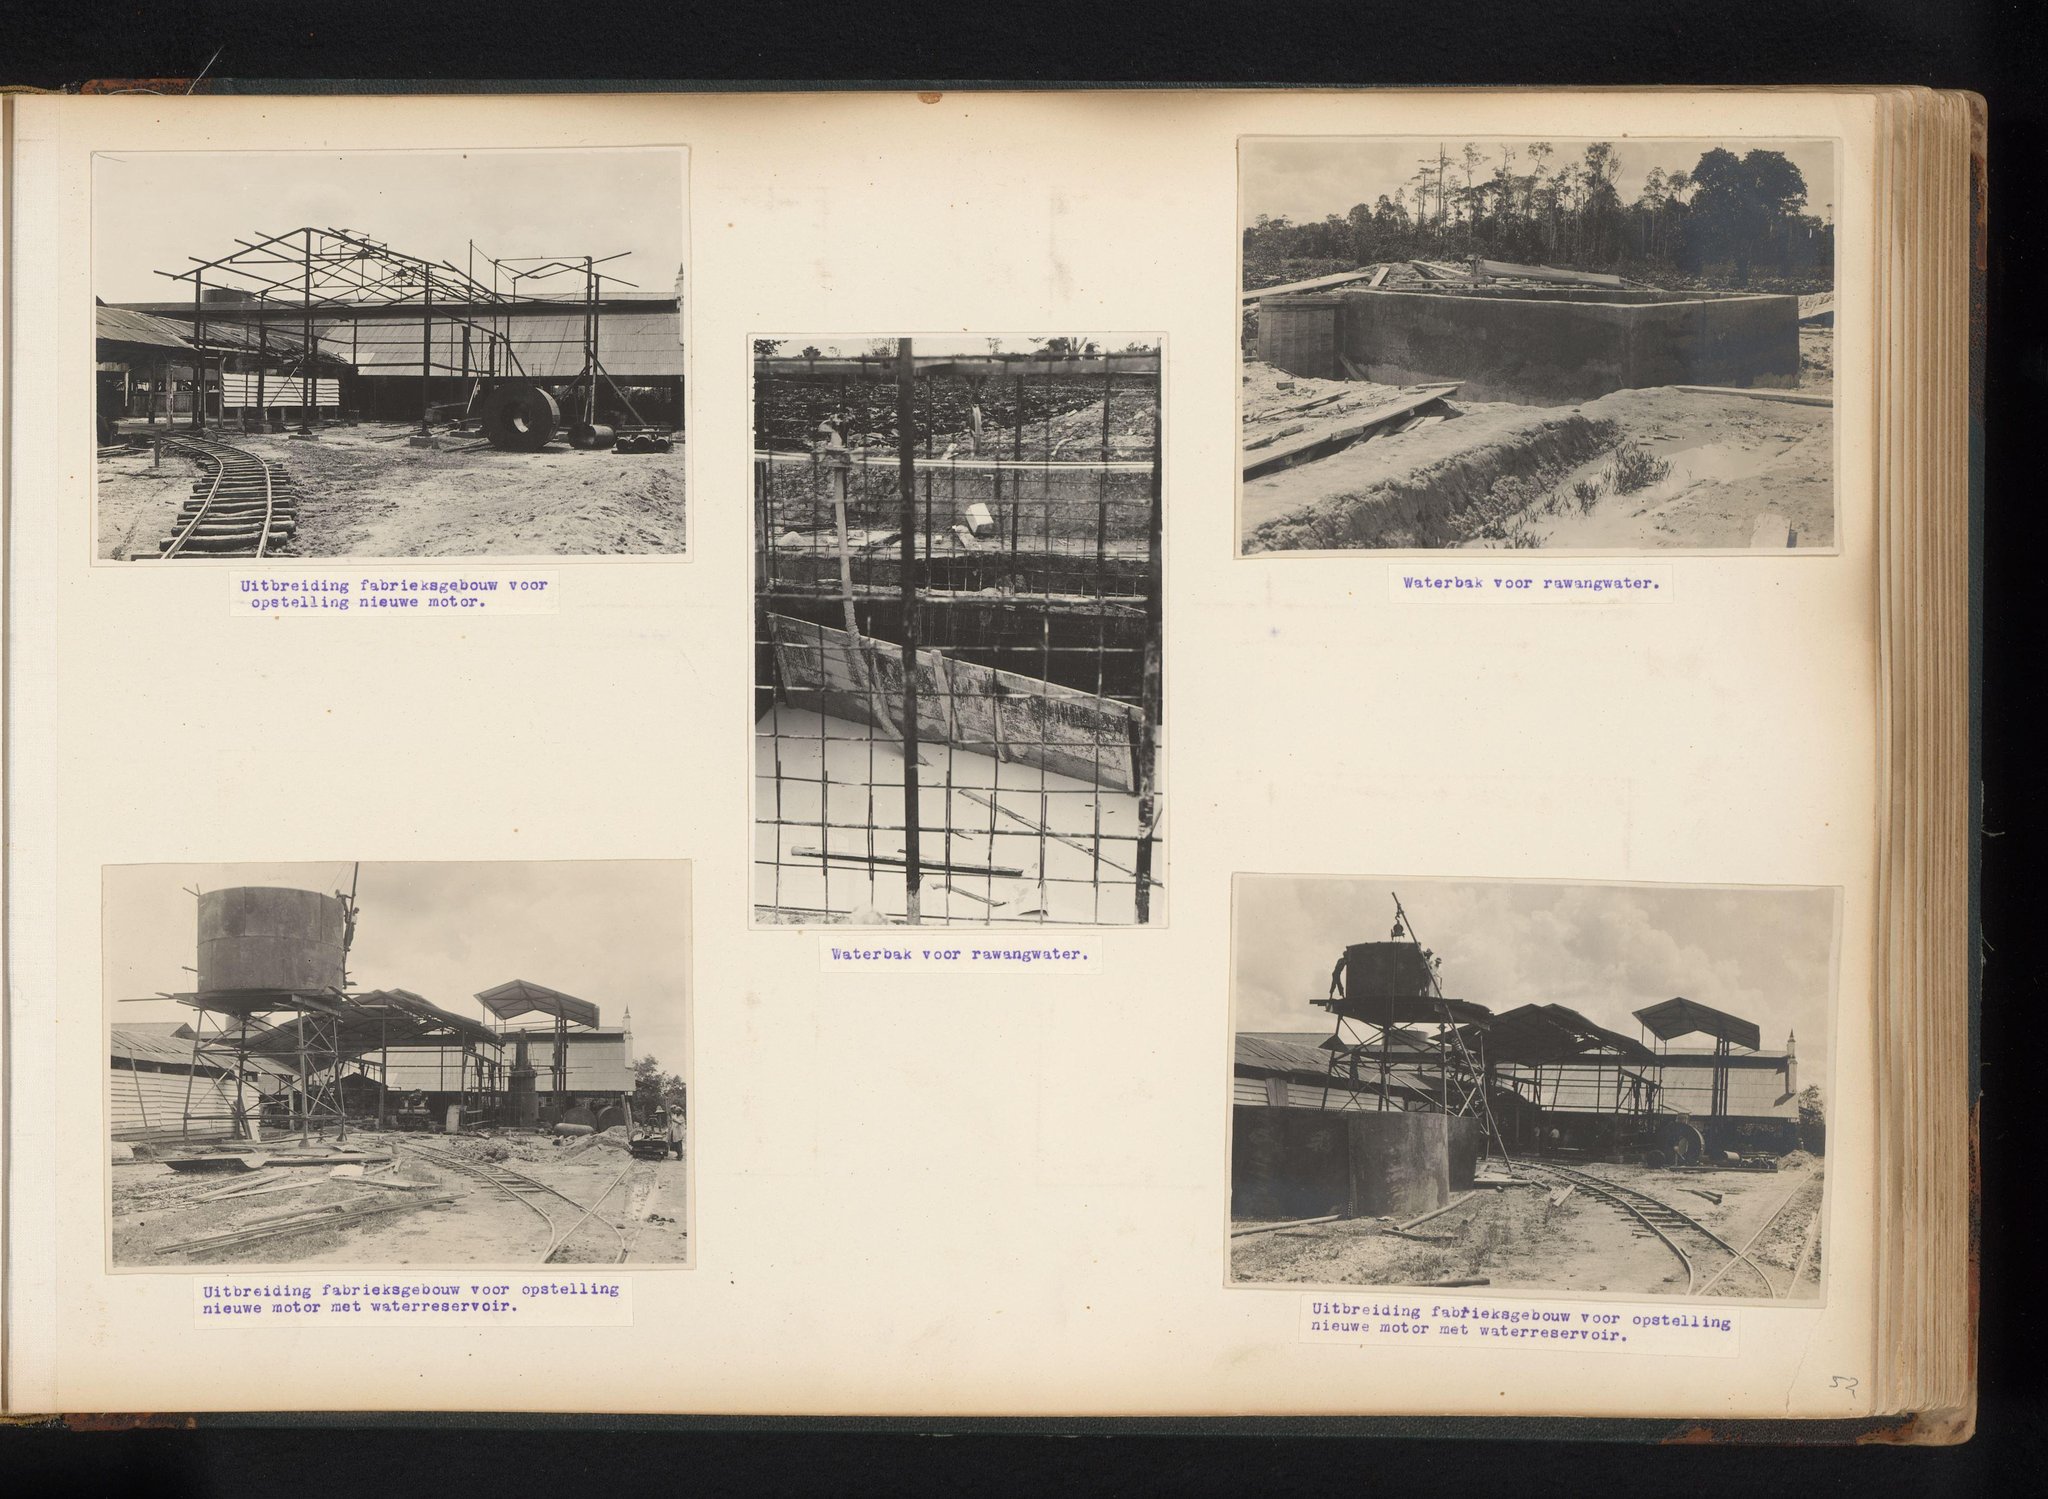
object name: photograph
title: Uitbreiding fabrieksgebouw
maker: Anonymous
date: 1906-1927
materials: cardboard, photographic support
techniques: gelatin silver print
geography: sumatra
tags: plantation, (non-fruit) products of plants or trees: rubber, exterior of industrial structures, factories, sumatra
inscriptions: inscription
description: Blad met vijf foto's van de uitbreiding van het fabrieksgebouw en de nieuwe waterbak, juni 1927. Onder de foto's etiketten met onderschriften. Onderdeel van het fotoalbum over de plantages Brussel en Pernantian van de Sumatra Caoutchouc Maatschappij op de Oostkust van Sumatra in de jaren 1910-1935.